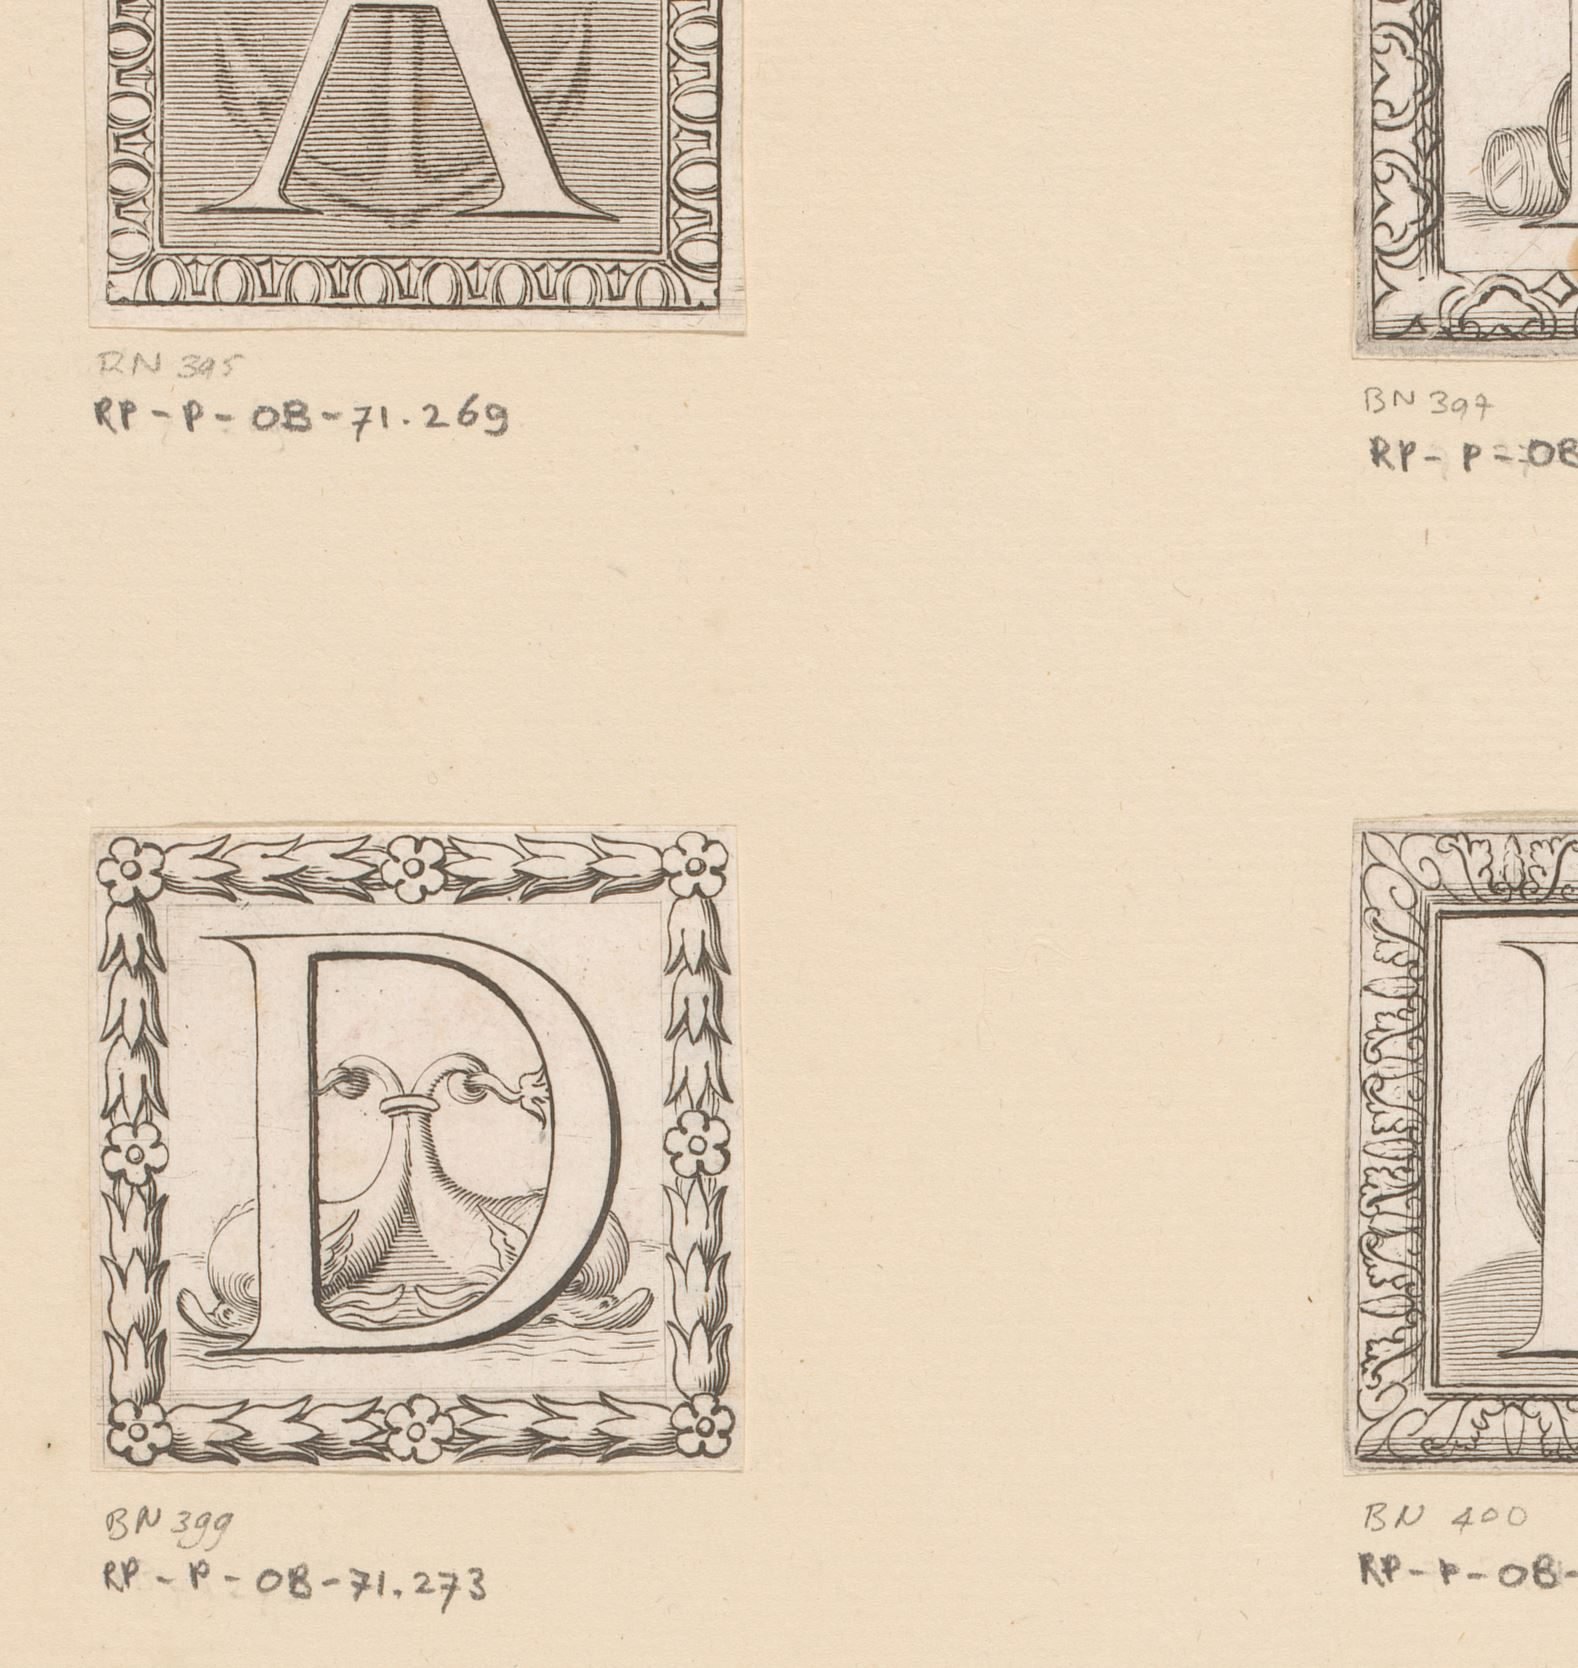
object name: print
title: Letter D met twee dolfijnen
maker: claude mellan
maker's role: draughtsman, print maker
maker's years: 1598-1688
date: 1639-1643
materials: paper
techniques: engraving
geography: paris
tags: decoration of printed matter, swimming mammals: dolphin, letters, alphabet, script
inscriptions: collector's mark: Lugt 240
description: Dit betreft één van de 21 letters die Mellan voor de Imprimerie Royale vervaardigde. Elke letter wordt vergezeld door een afbeelding van een onderwerp dat met dezelfde letter begint. Tussen 1639-1643 werkte Mellan samen met de Imprimerie Royale (IFF 17e siècle, p. 21-22). Hij vervaardigde verschillende vignetten, letters, culs-de-lampe en decoratieve banden (IFF 17e siècle, p. 215-220).